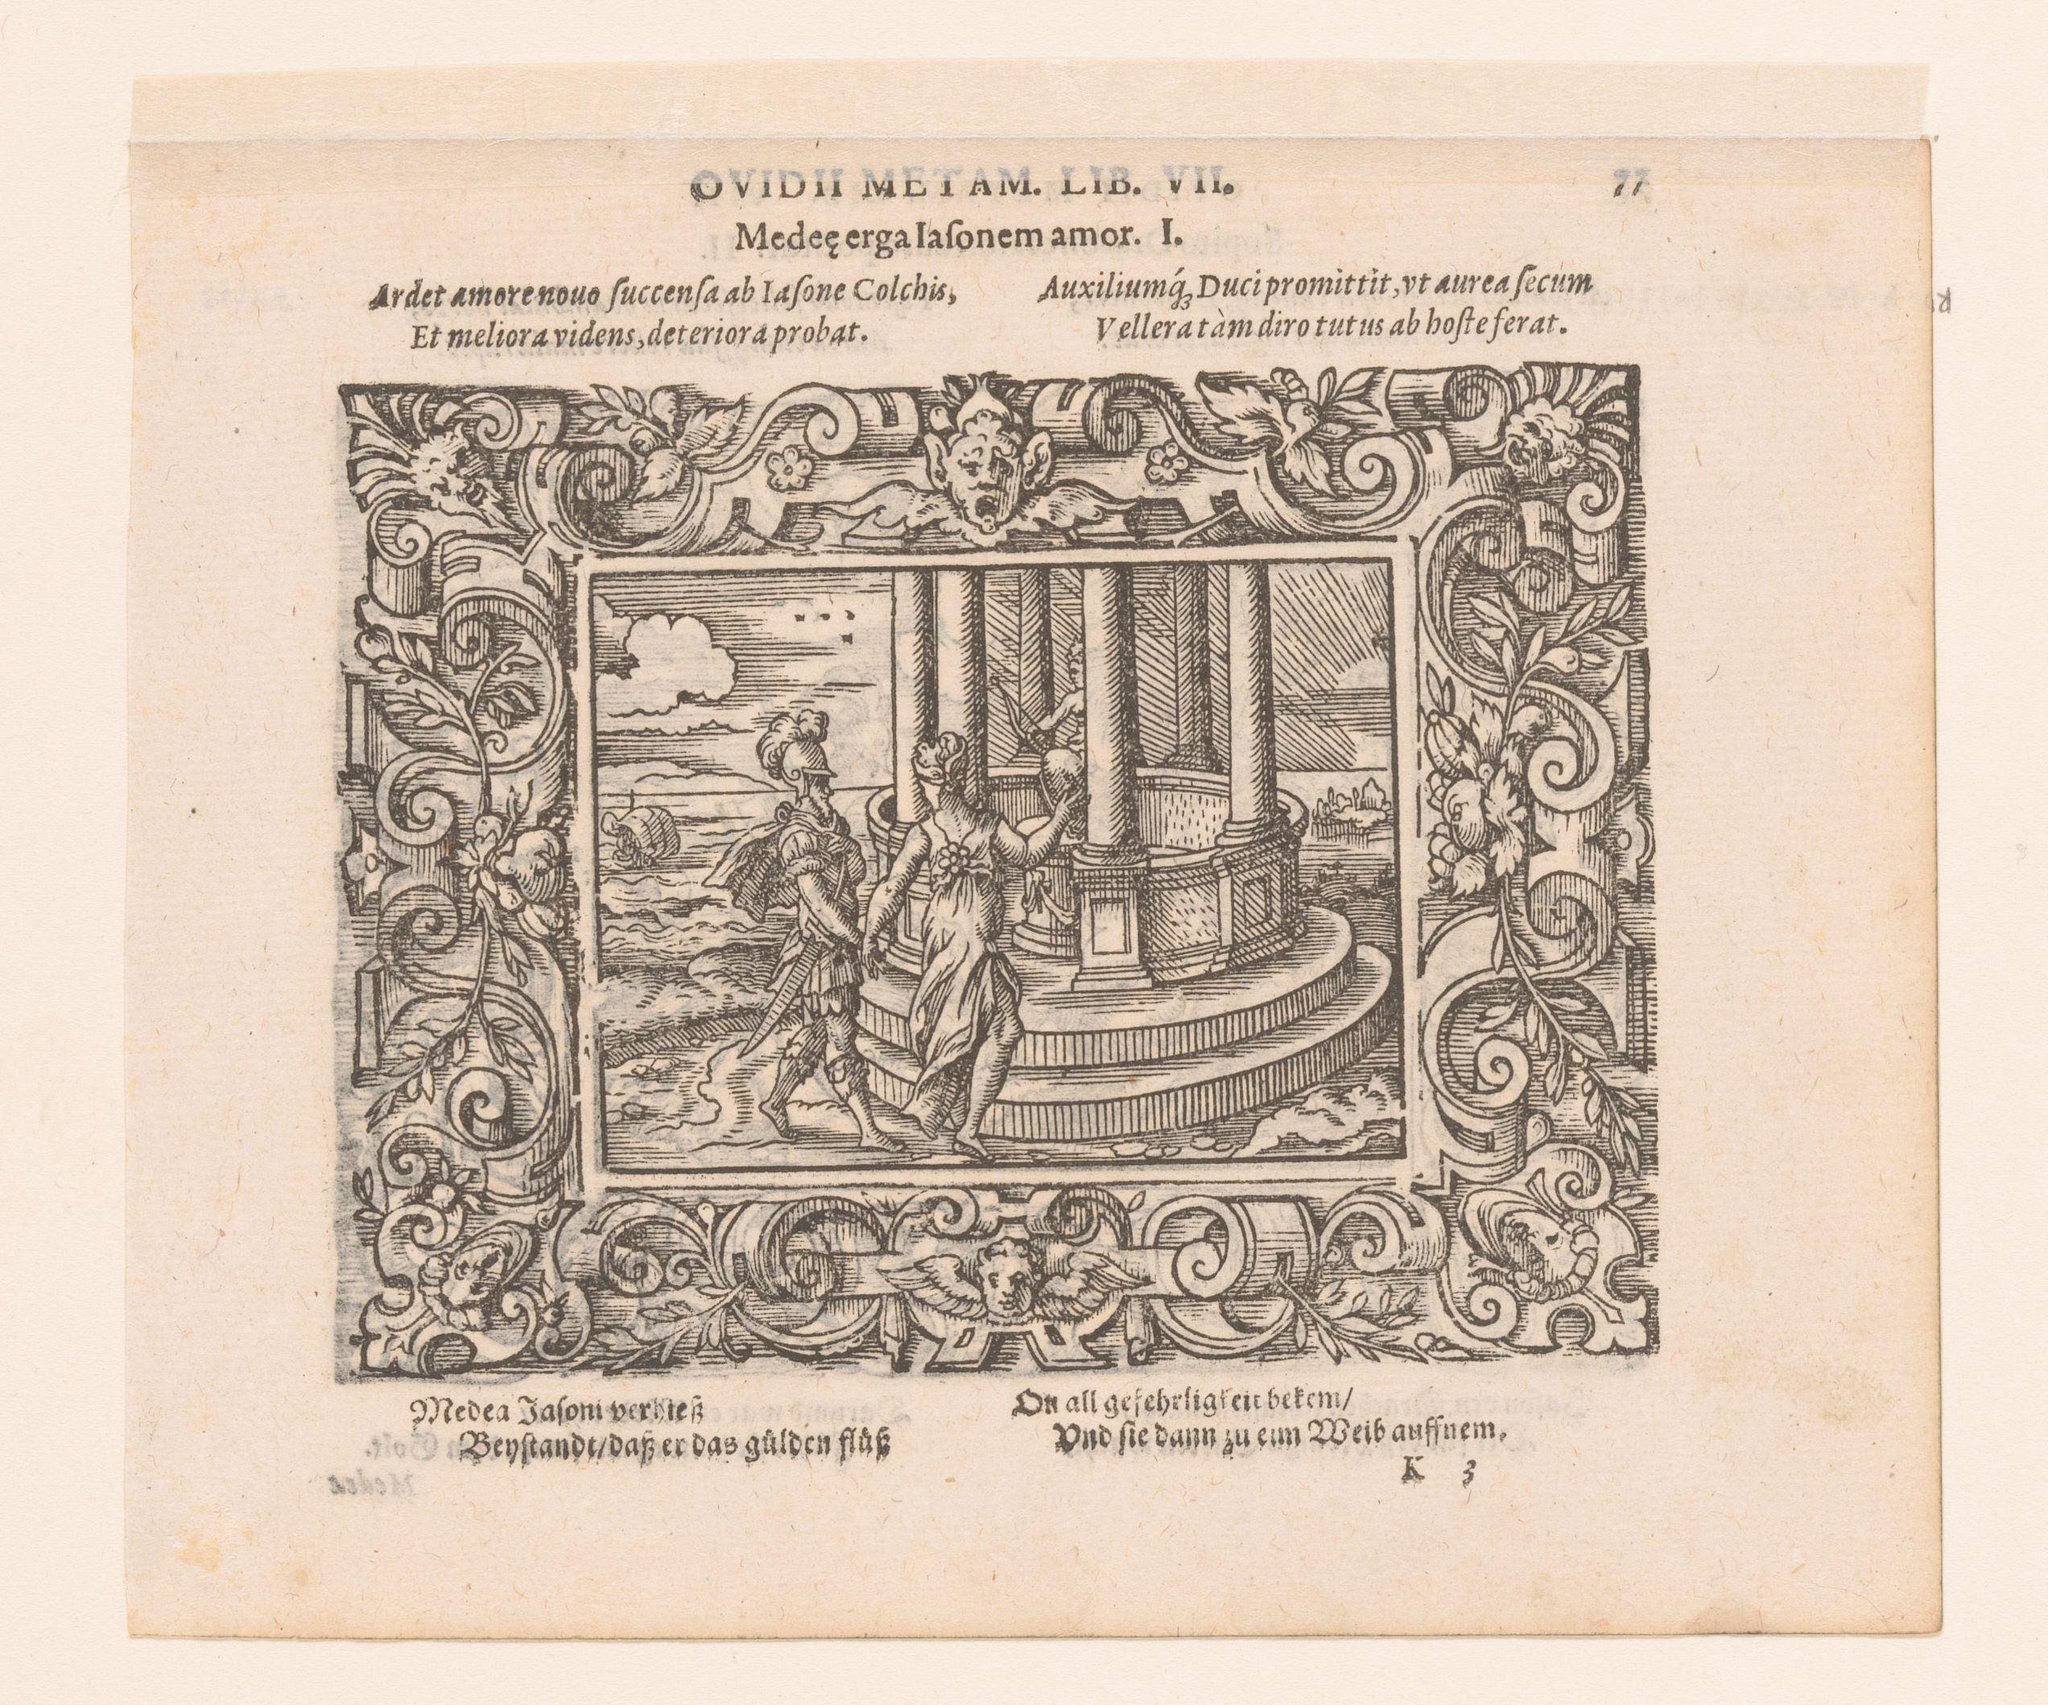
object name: book illustration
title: Jason en Medea bij het altaar van Diana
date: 1569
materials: paper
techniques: letterpress printing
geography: frankfurt am main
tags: scrollwork, strapwork ~ ornament, jason and medea at the altar of hecate (or diana): medea gives him a magic herb or ointment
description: Illustratie bij de Metamorfosen van Ovidius, afkomstig uit de publicatie: Posthius, Johannes. Tetrasticha in Ovidii metam. Frankfurt am Main: Georg Rab en Sigmund Feyerabend en erven Weigand Han, 1569. De voorstellingen en ornamentranden van deze boekillustraties zijn van twee aparte blokken gedrukt. Beide werden afzonderlijk van elkaar ook gebruikt voor andere publicaties, en de ornamentranden werden eveneens binnen deze publicatie meerdere keren gebruikt.